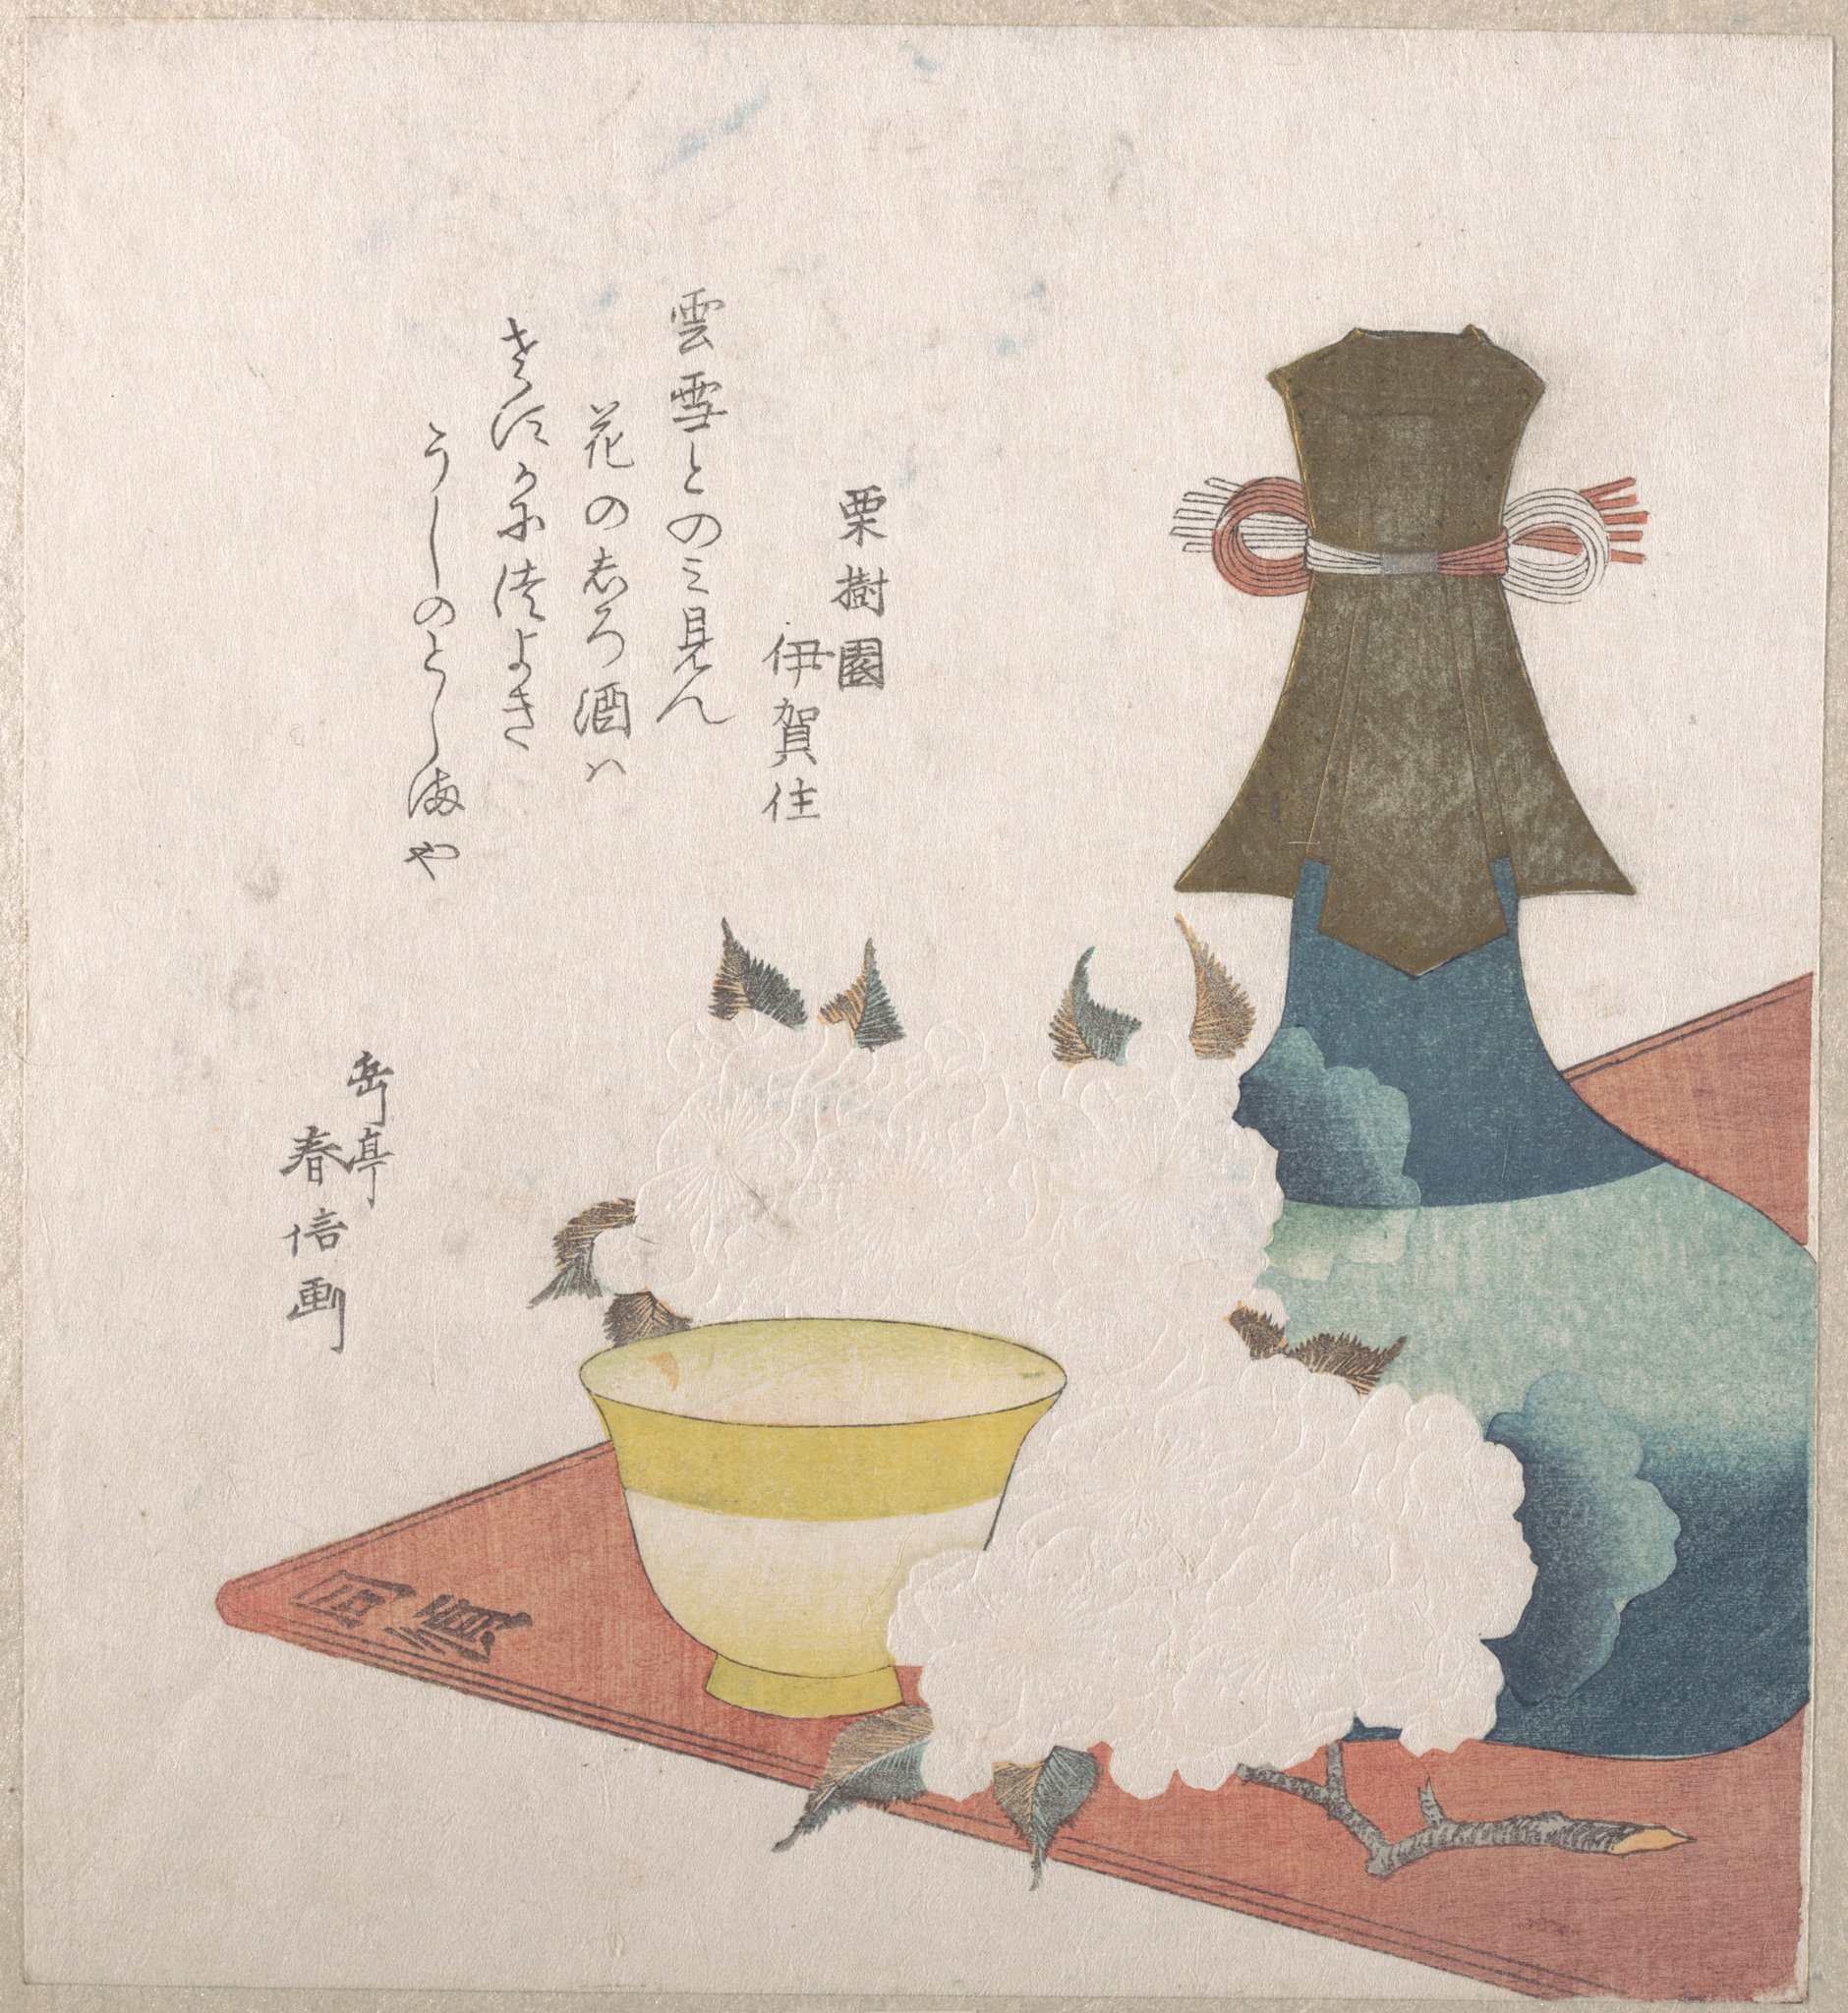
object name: woodblock print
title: Wine Bottle, Cup and Cherry Blossoms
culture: japanese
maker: yashima gakutei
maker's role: artist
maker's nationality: japanese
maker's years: 1786-1868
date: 1817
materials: ink, paper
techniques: surimono, woodblock print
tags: flowers